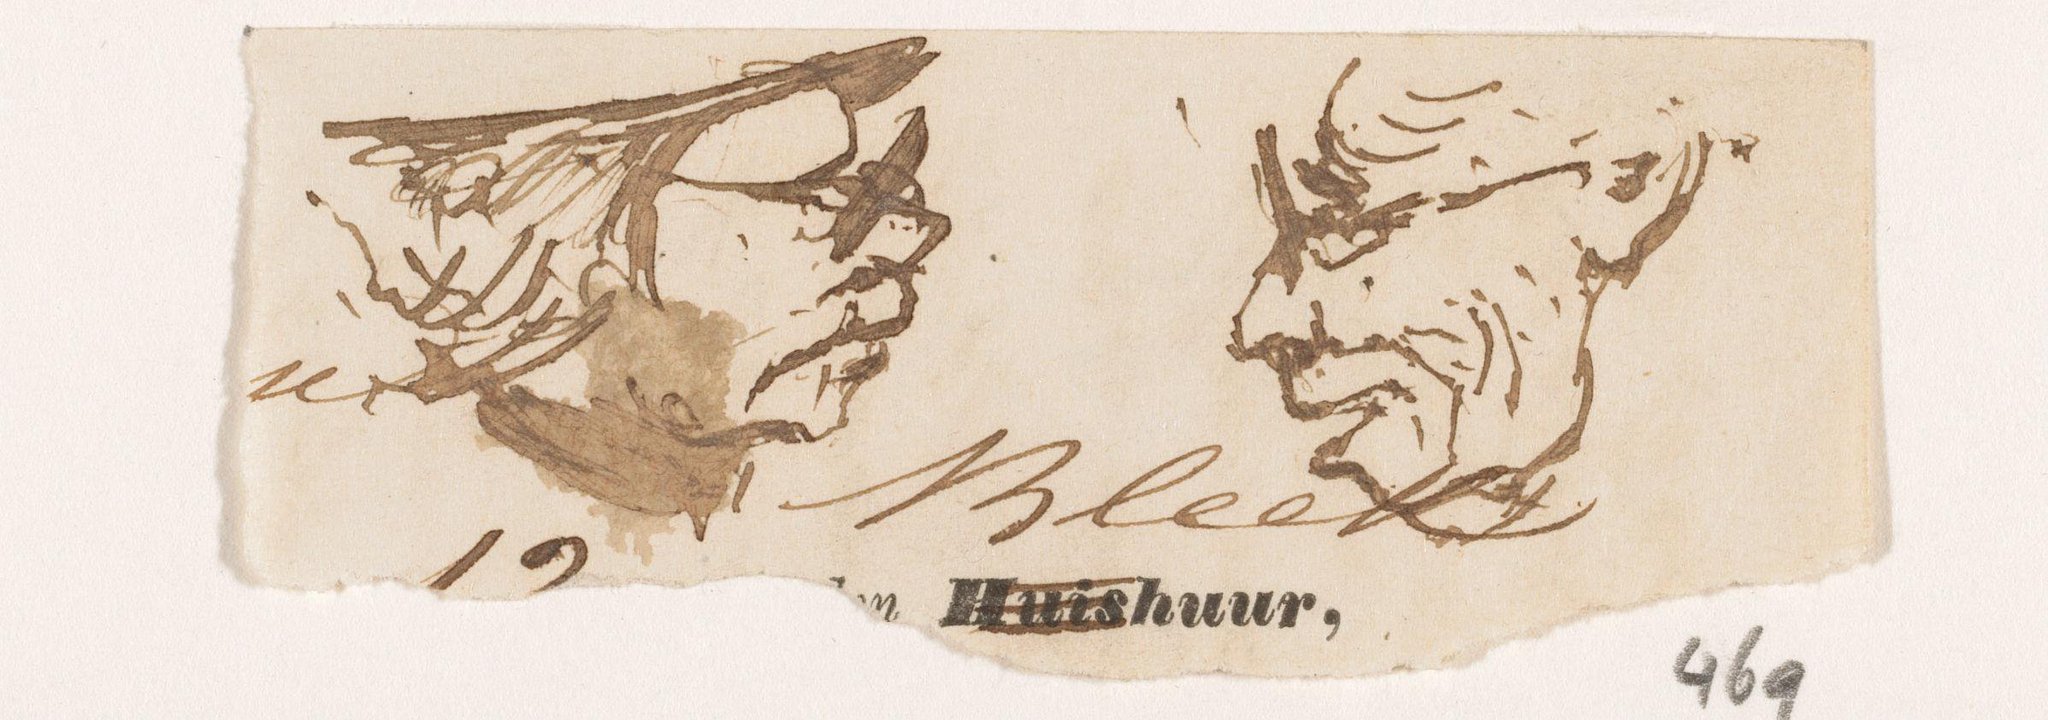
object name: drawing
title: Twee koppen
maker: johannes tavenraat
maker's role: draughtsman, painter, print maker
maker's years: 1809-1881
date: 1840-1880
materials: ink, paper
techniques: pen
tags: caricatures (human types)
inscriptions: collector's mark: Lugt 2228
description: Twee koppen. Getekend op de achterzijde van een fragment van een brief.